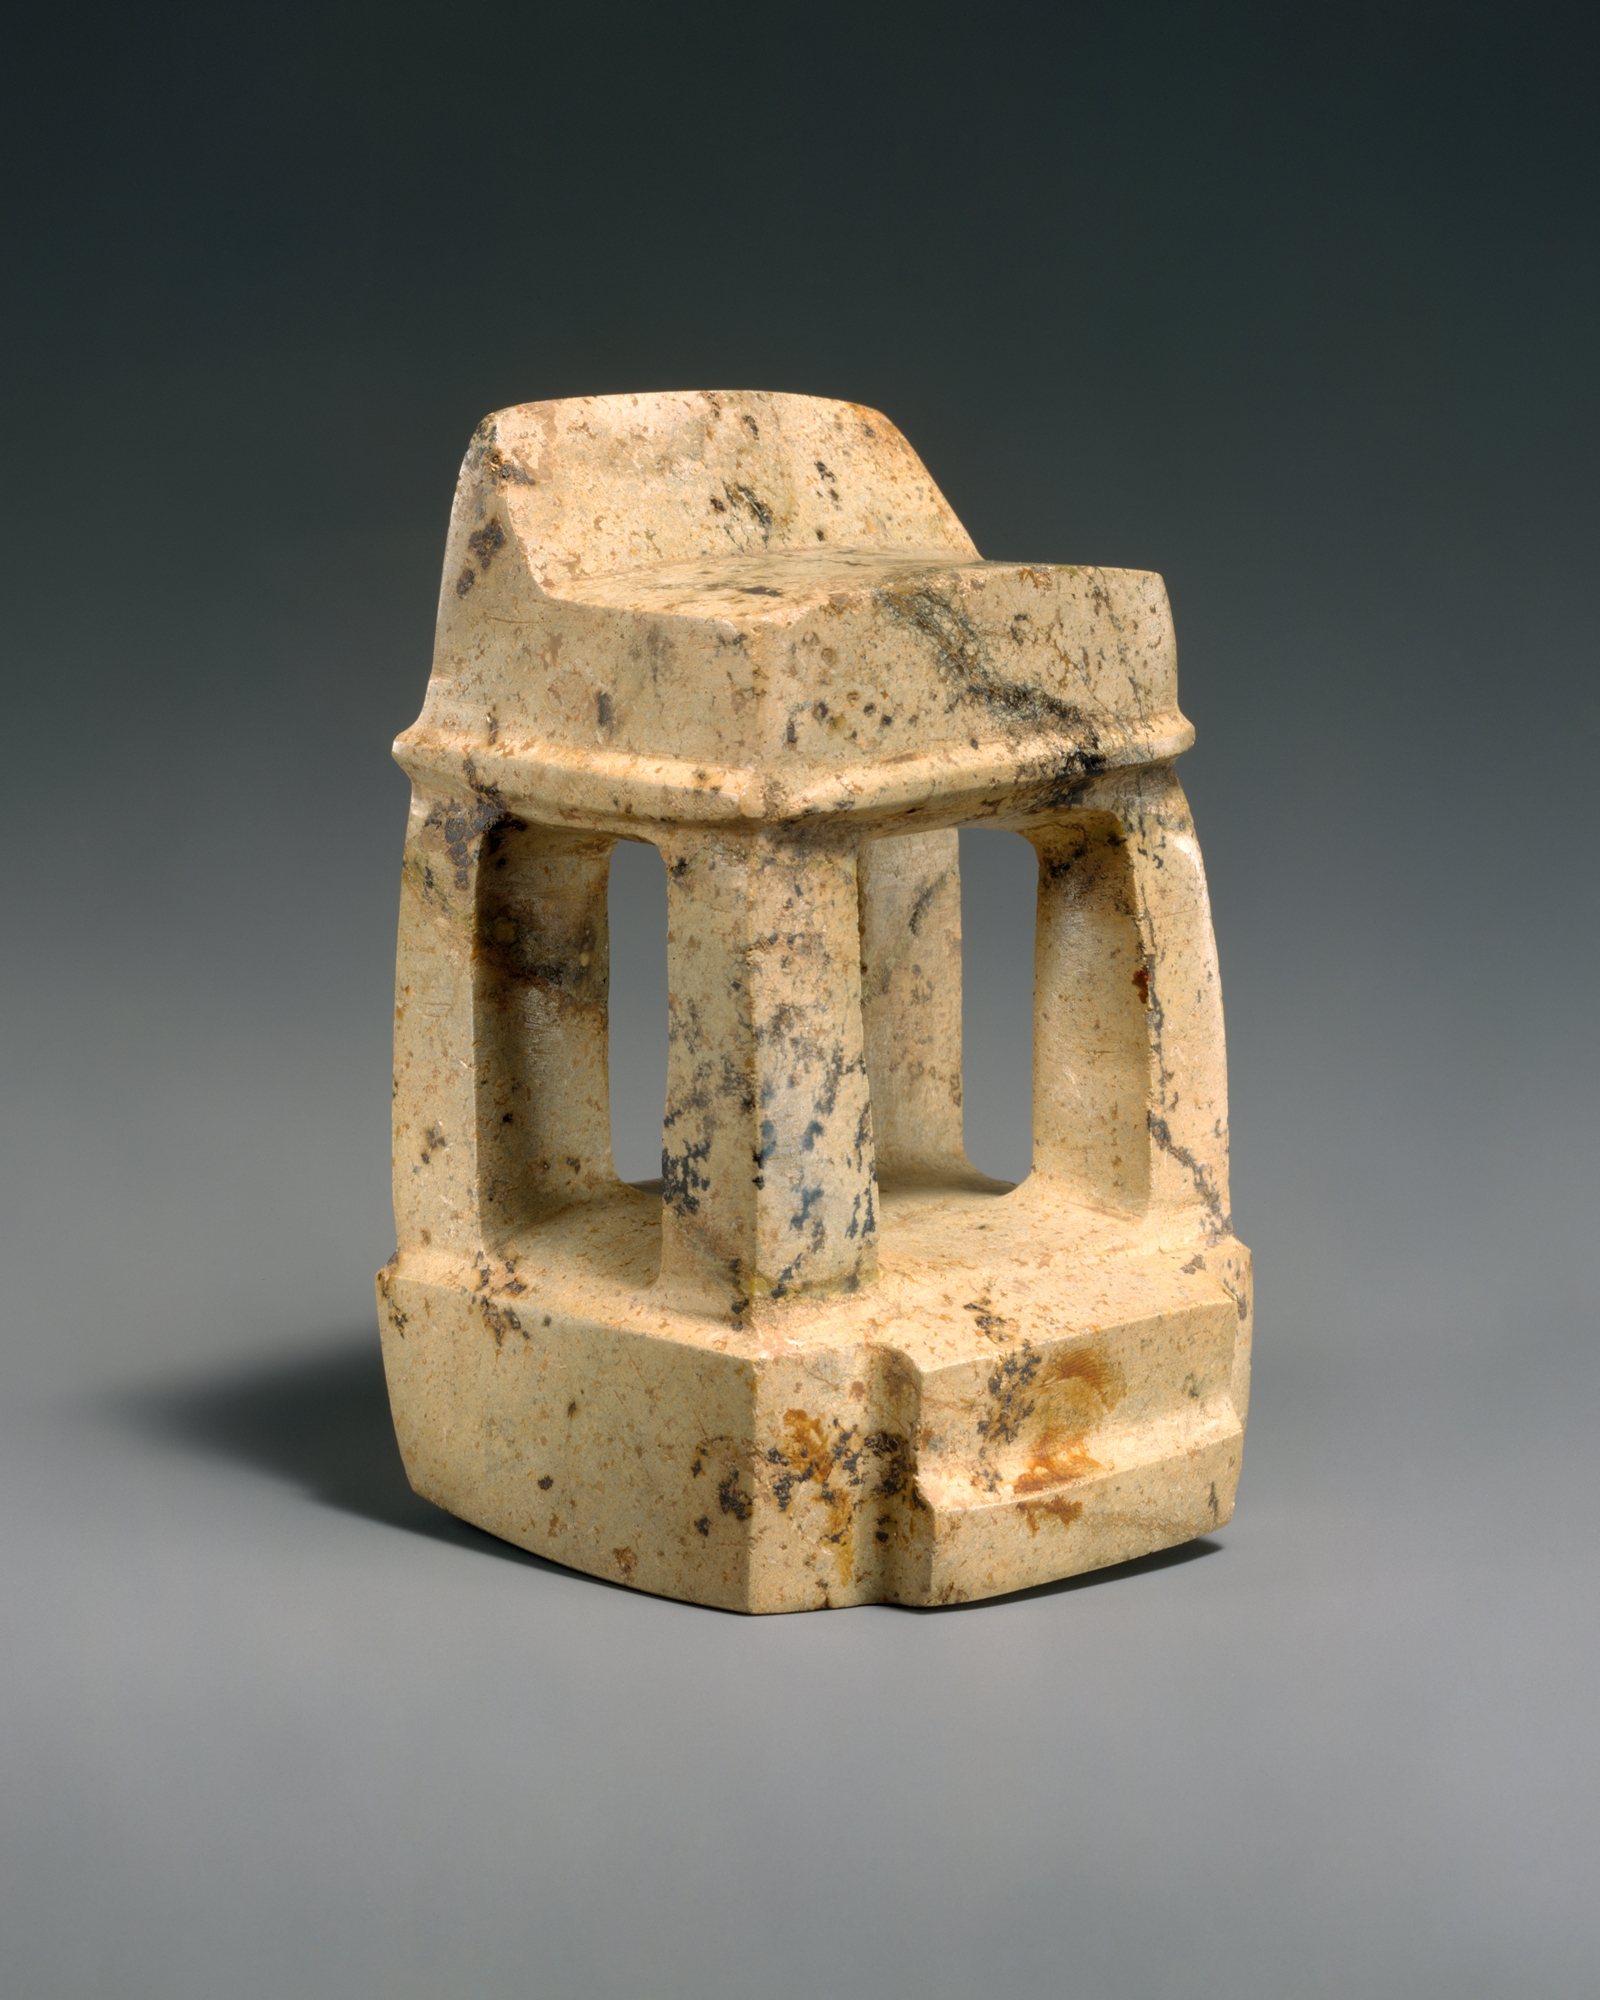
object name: architectural model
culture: mezcala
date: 1-800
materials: stone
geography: mexico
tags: temples